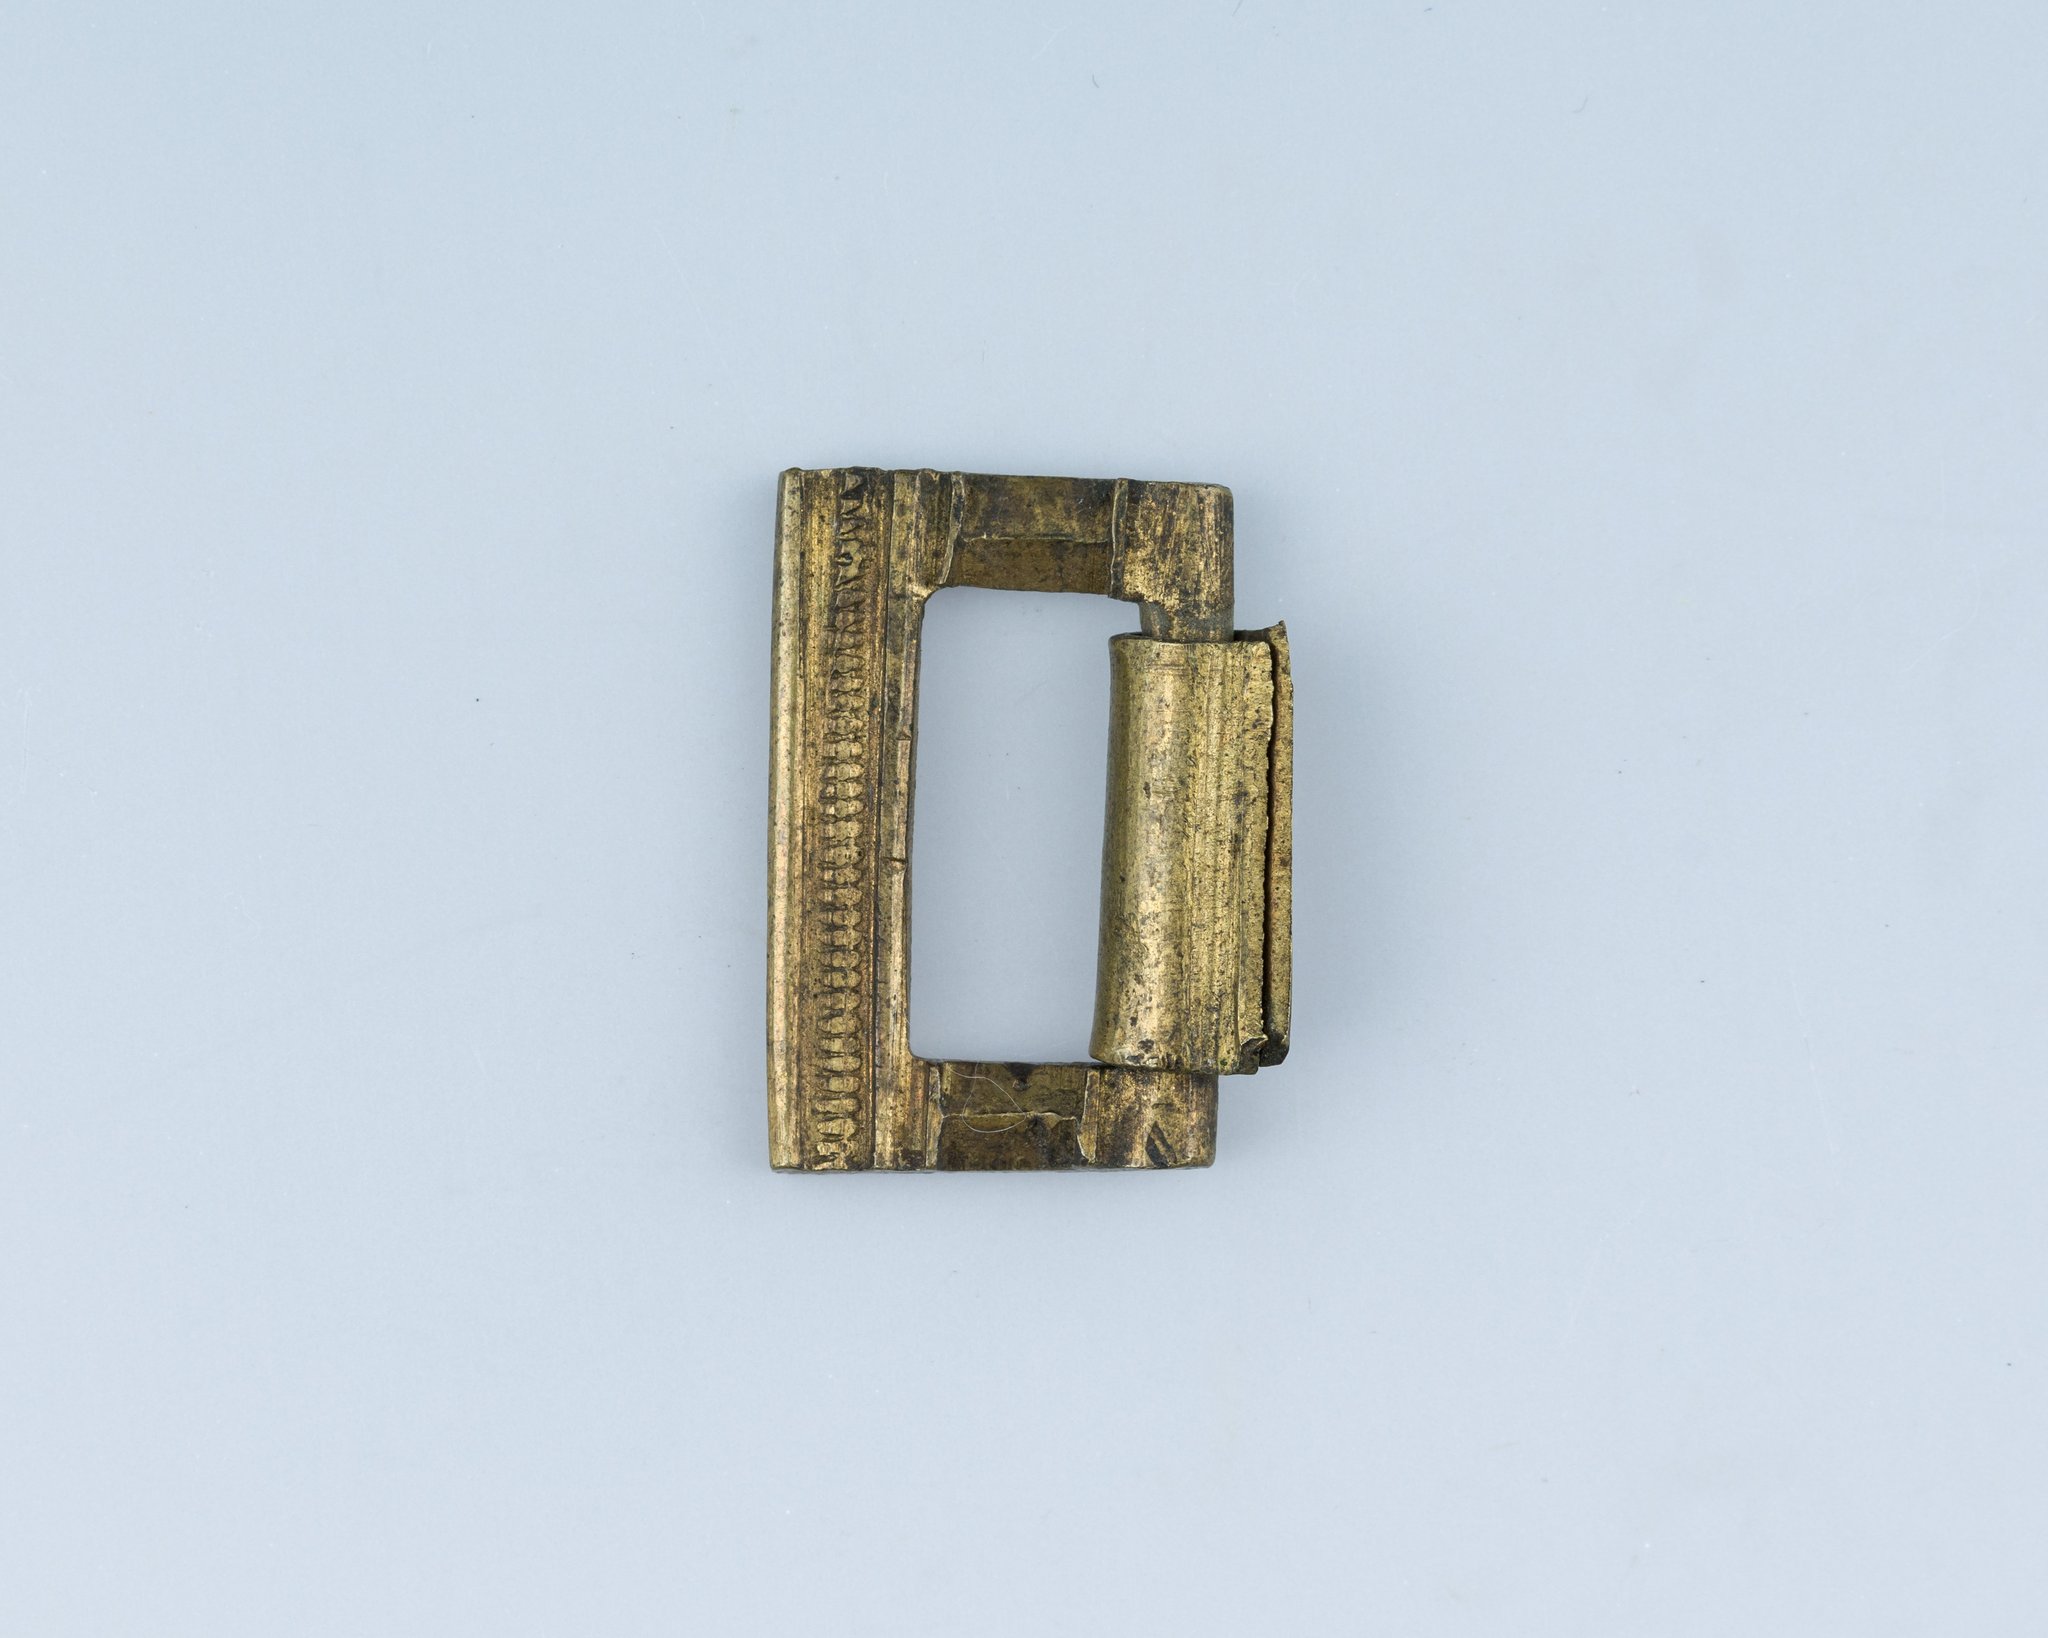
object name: buckle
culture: german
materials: brass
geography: germany